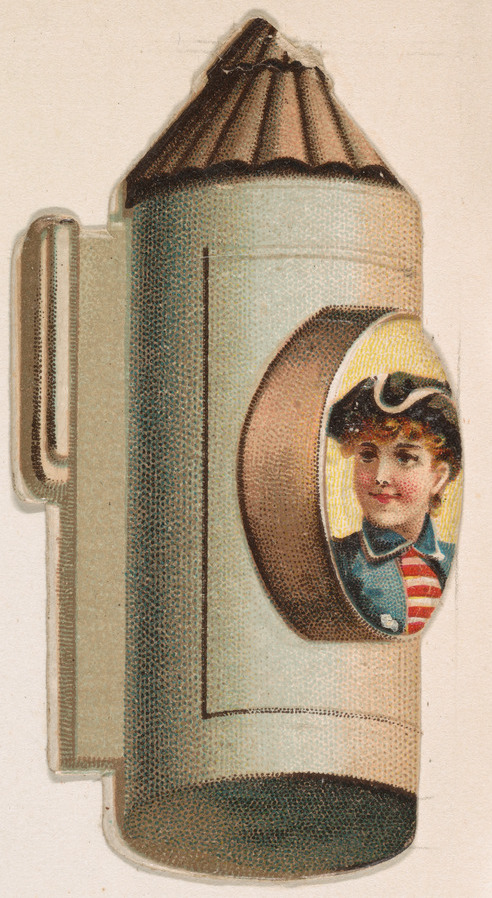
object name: print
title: Lantern, from the Novelties series (N228, Type 4) issued by Kinney Bros.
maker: kinney brothers tobacco company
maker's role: publisher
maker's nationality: american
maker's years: 1869-2011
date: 1889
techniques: color lithograph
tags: women,lanterns